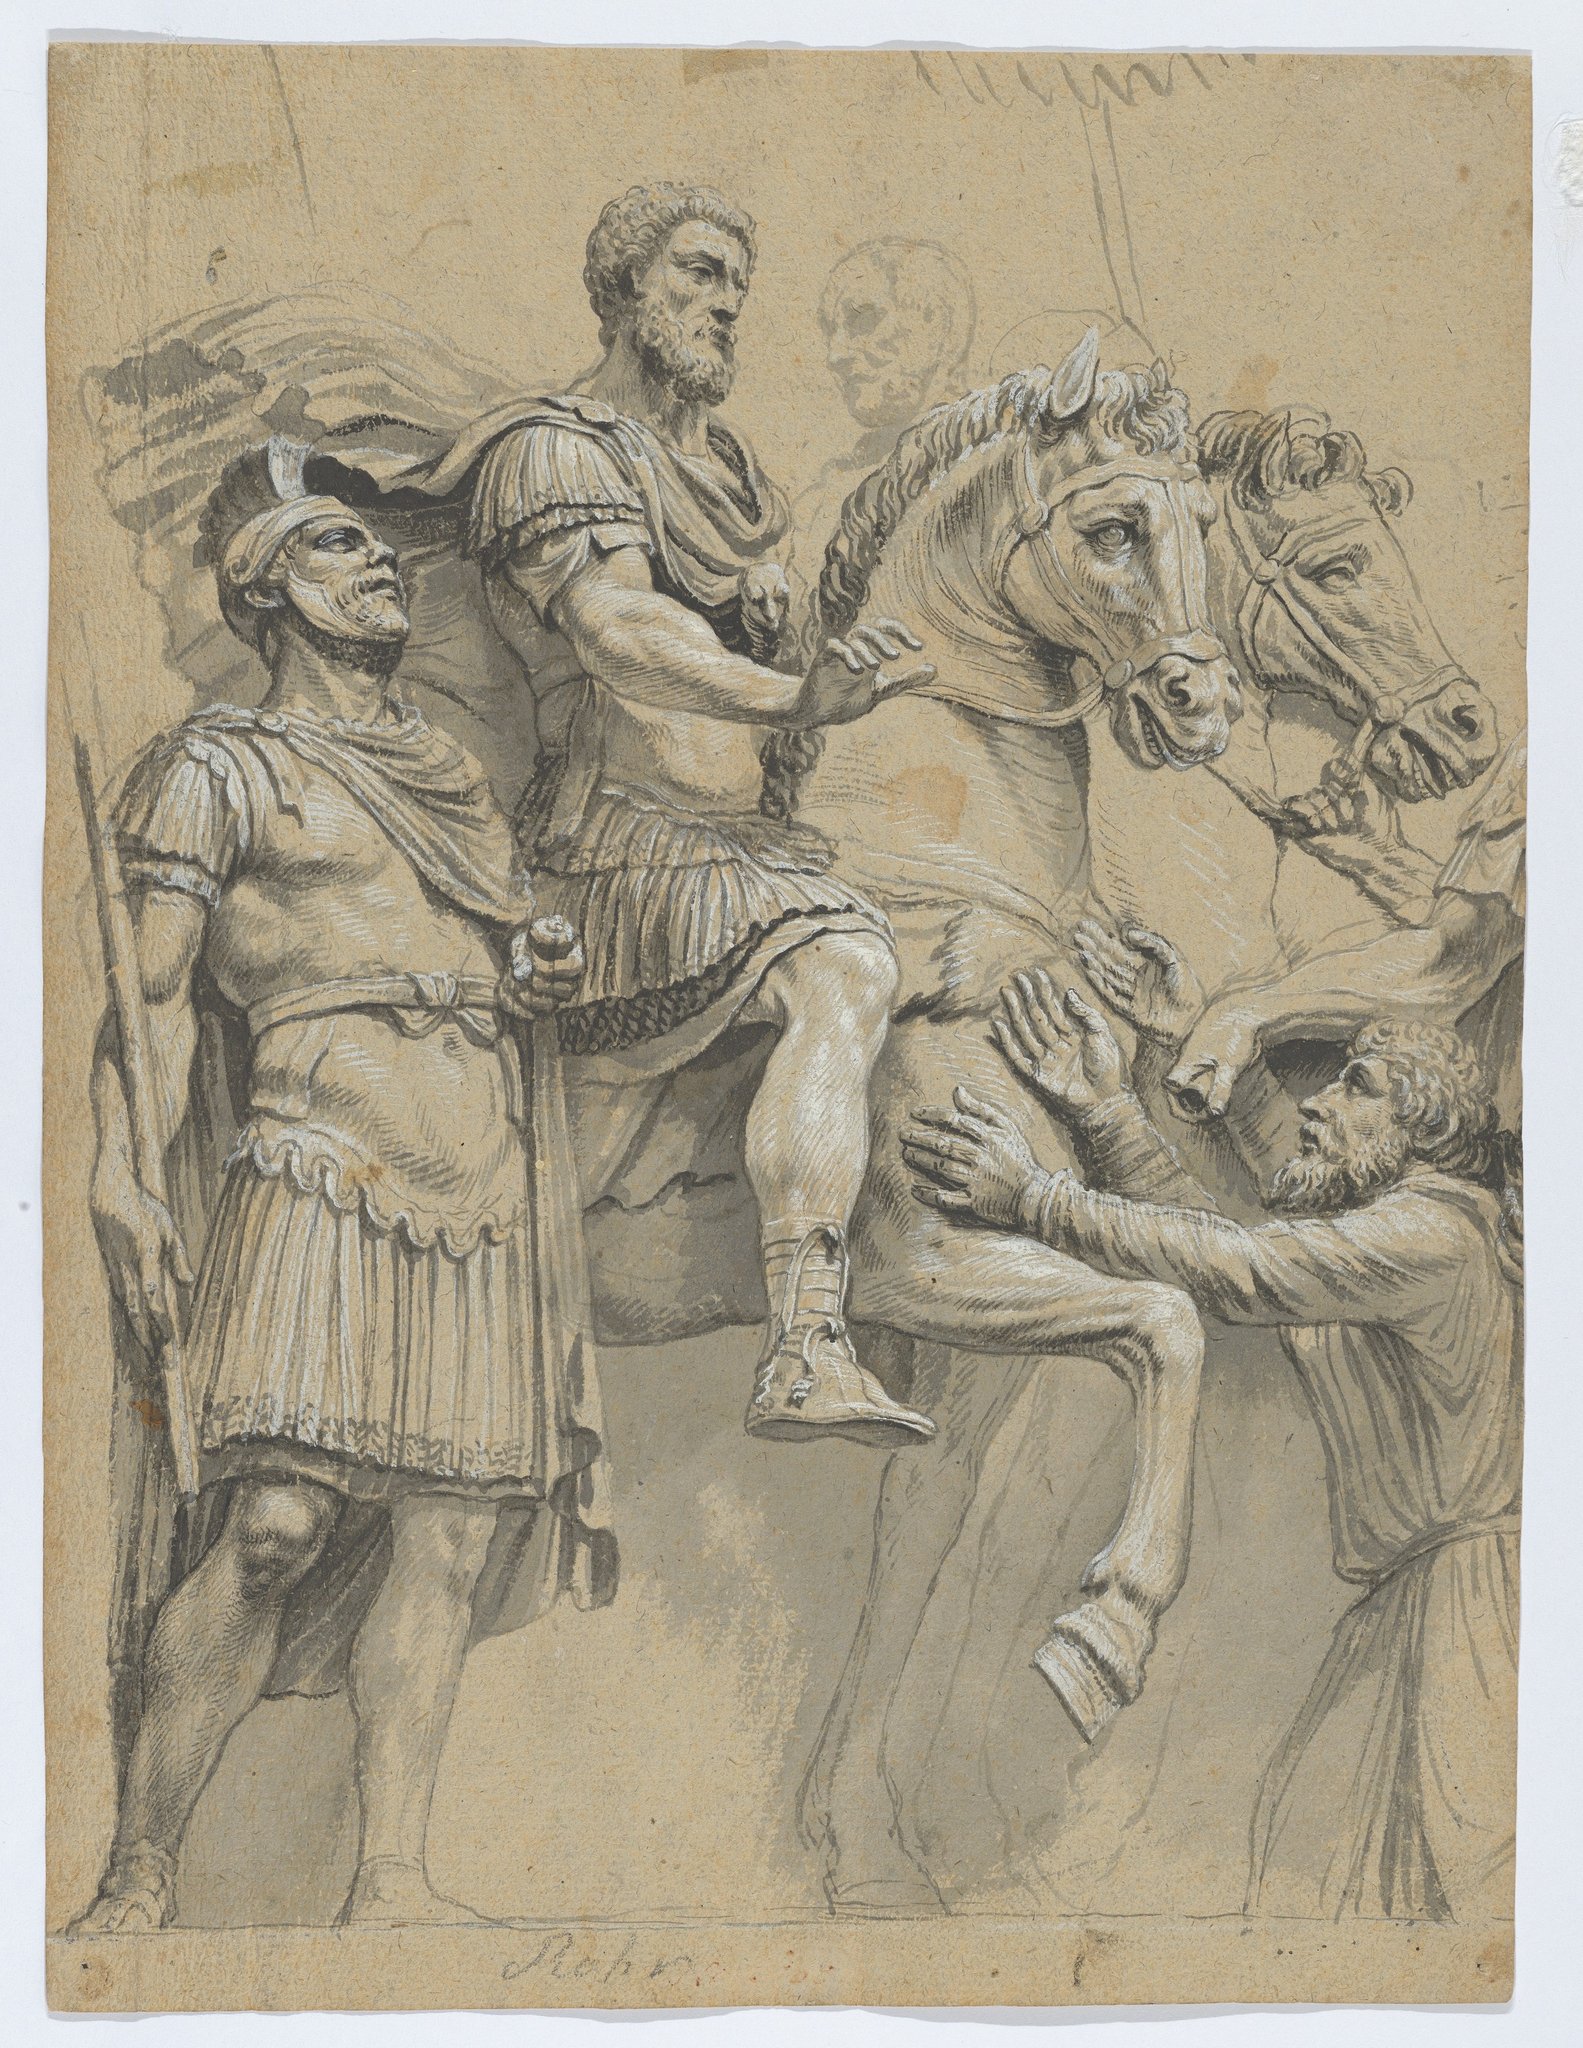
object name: drawing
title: Marcus Aurelius on Horseback (recto); Study of an Antique Vase (verso)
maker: anonymous, german, 17th century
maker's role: artist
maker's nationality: german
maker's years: 1600-1700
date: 1601-1700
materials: gouache, ink, paper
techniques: brush, heightening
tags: kings,men,horses